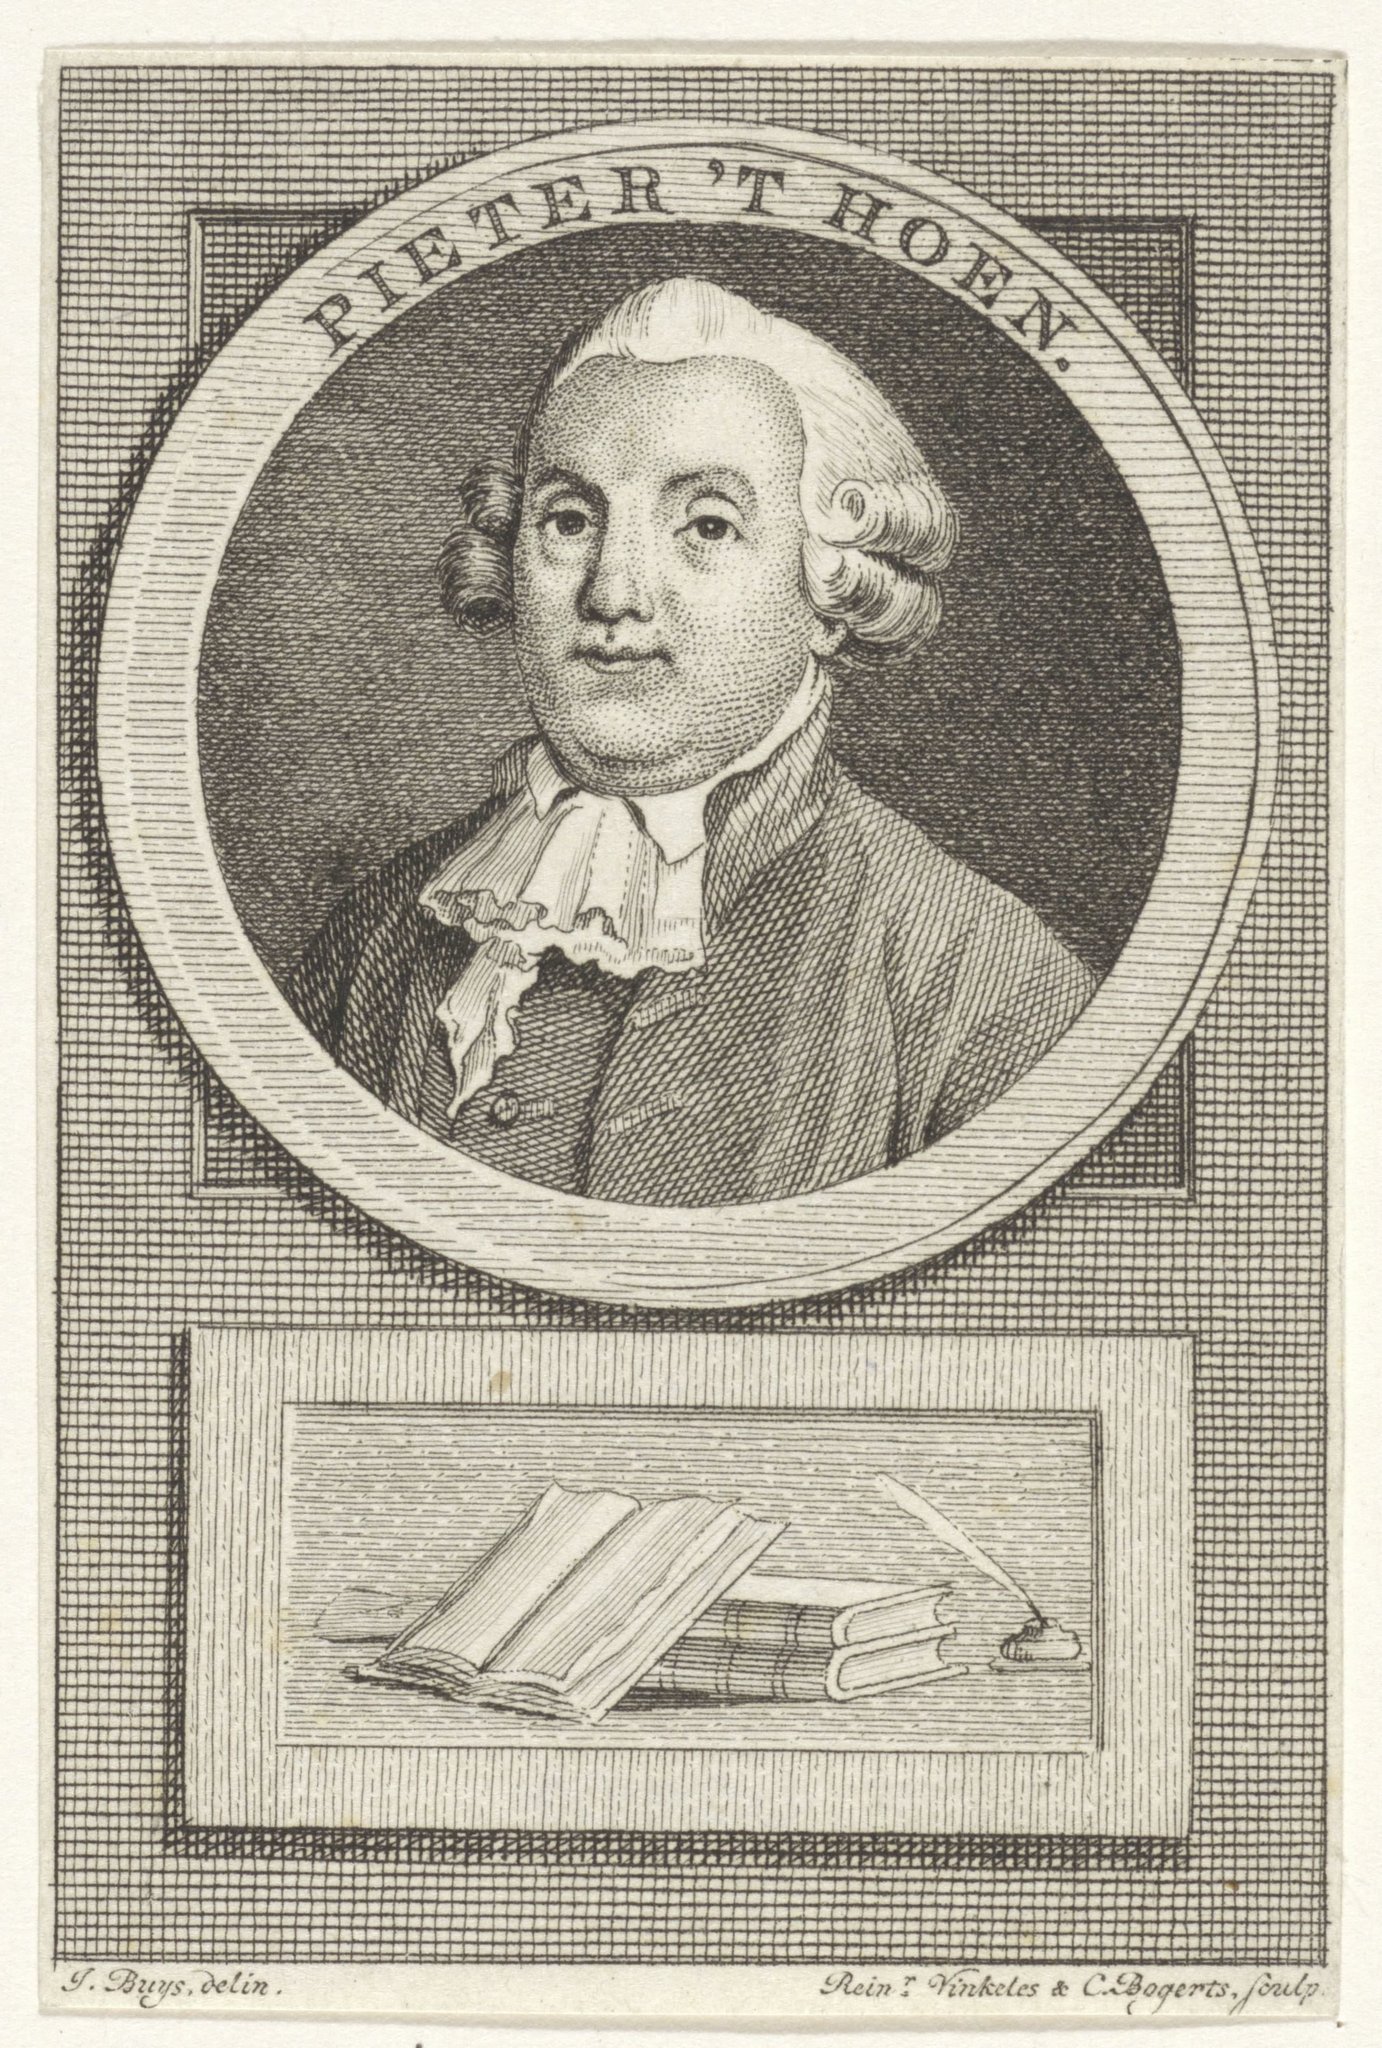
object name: book illustration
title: Portret van Pieter 't Hoen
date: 1783-1795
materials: paper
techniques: engraving, etching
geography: amsterdam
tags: pieter 't hoen, ink-well, book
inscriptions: collector's mark: Lugt 2228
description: Prent gebruikt in: Fokke, Jan. Geschiedenissen der Vereenigde Nederlanden voor de vaderlandsche jeugd Ie-XXVste deel. Amsterdam: Johannes Allart, 1783-1795. Deel XXIII.